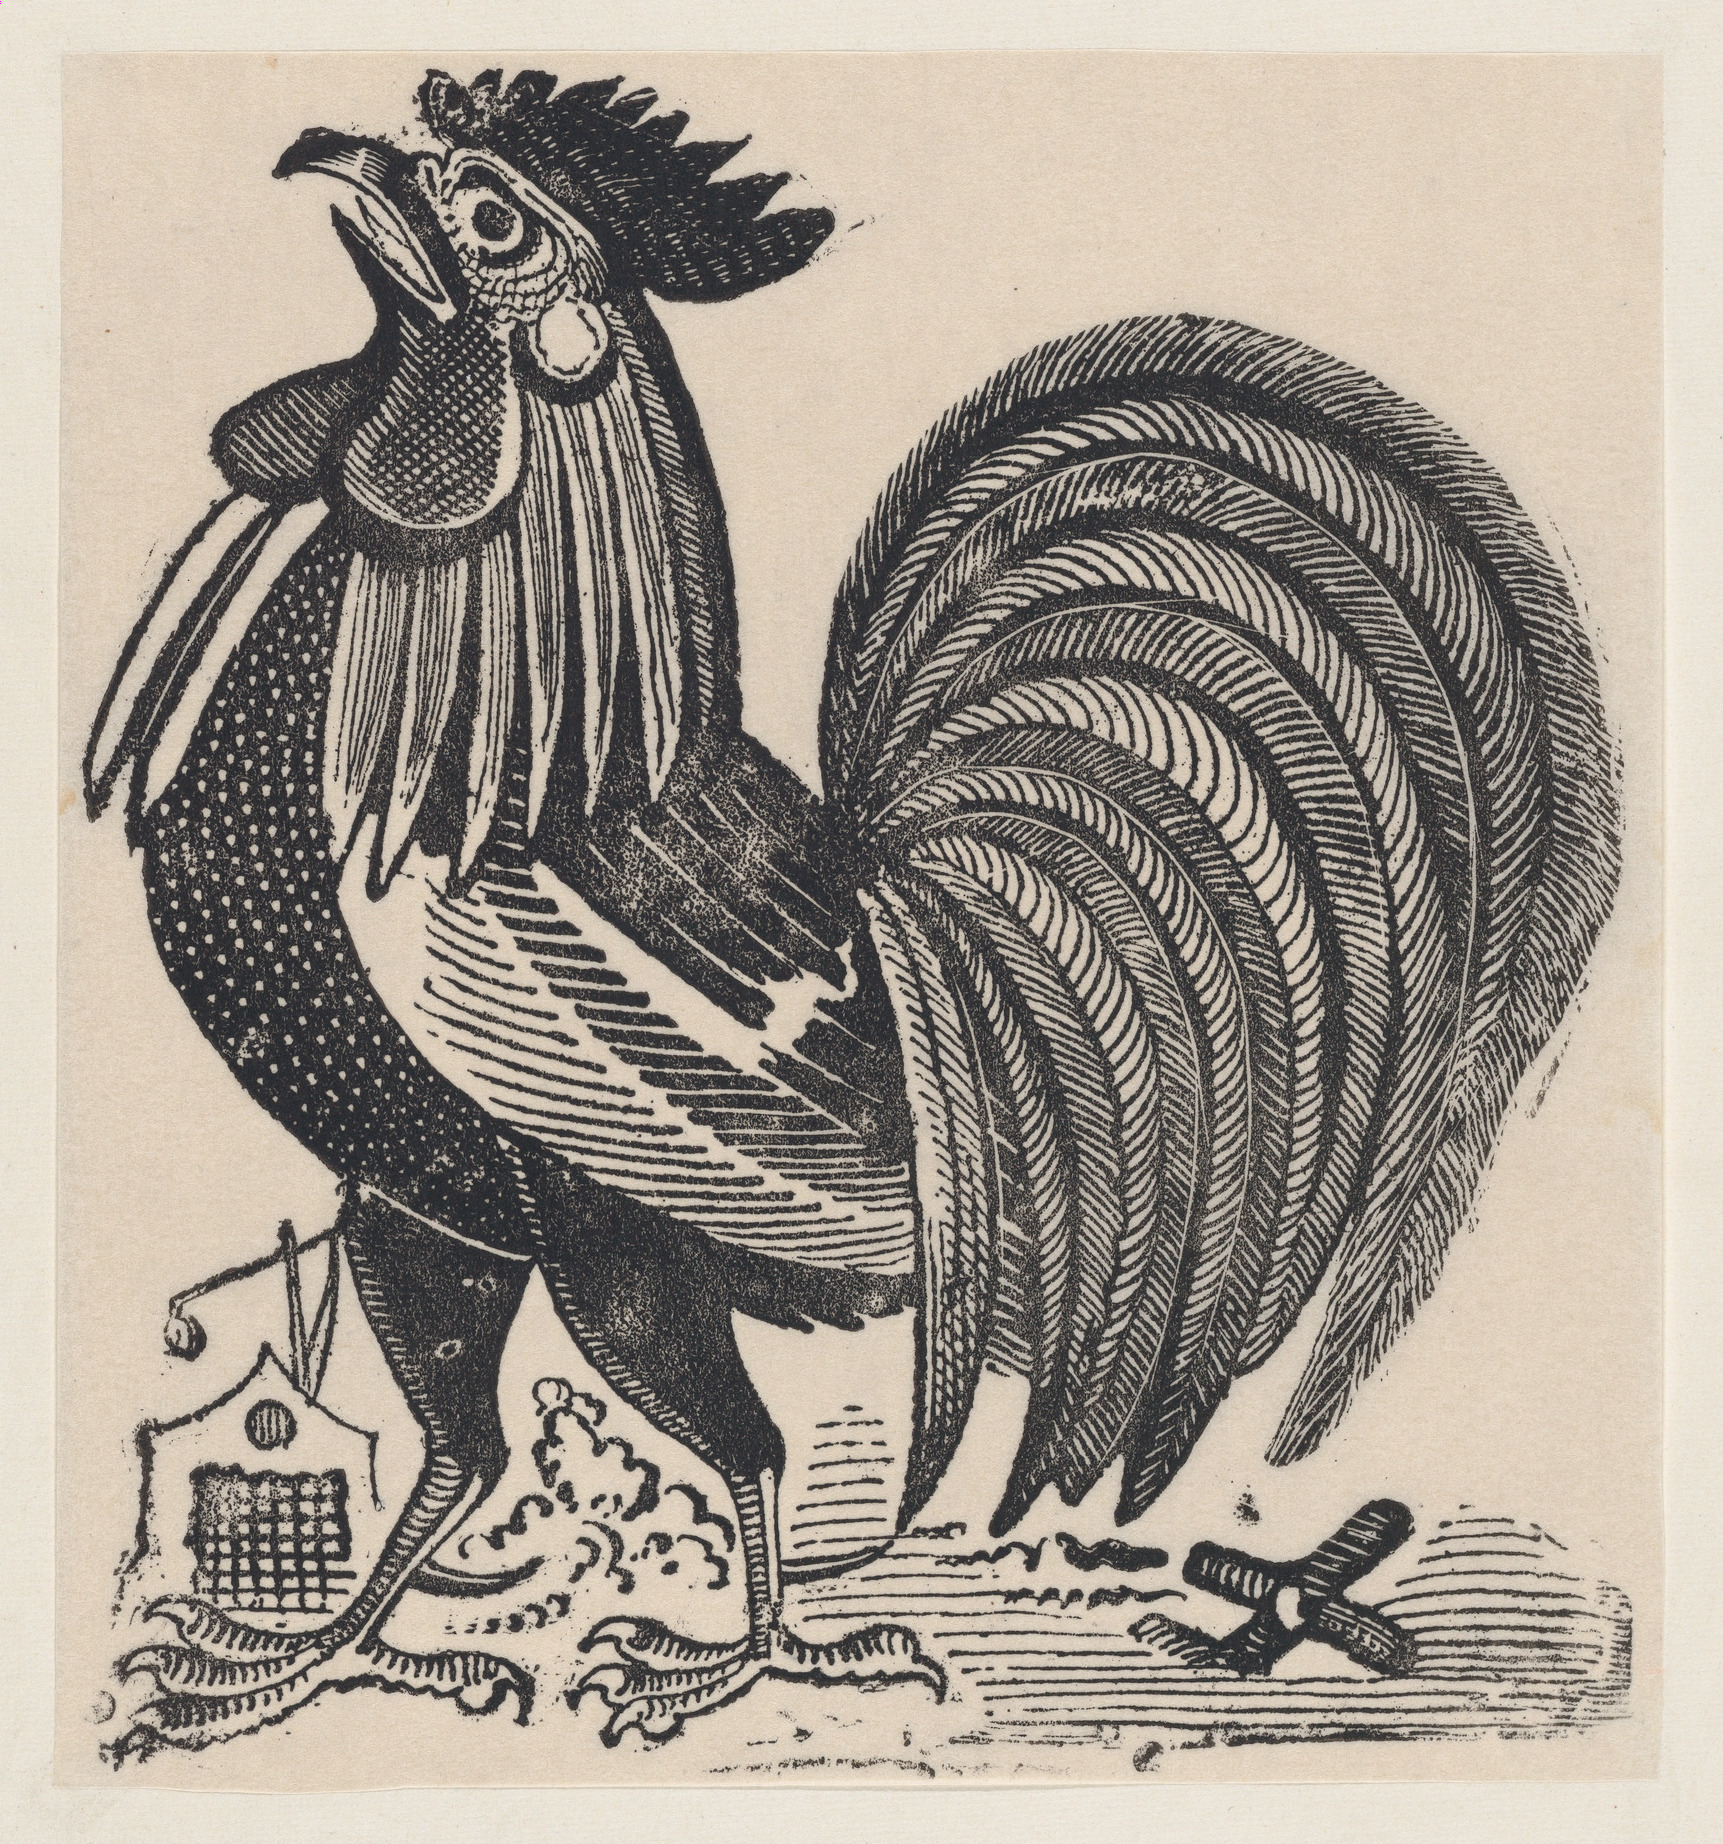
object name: print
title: A rooster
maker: josé guadalupe posada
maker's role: artist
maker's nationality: mexican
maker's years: 1852-1913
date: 1904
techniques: lithography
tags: roosters